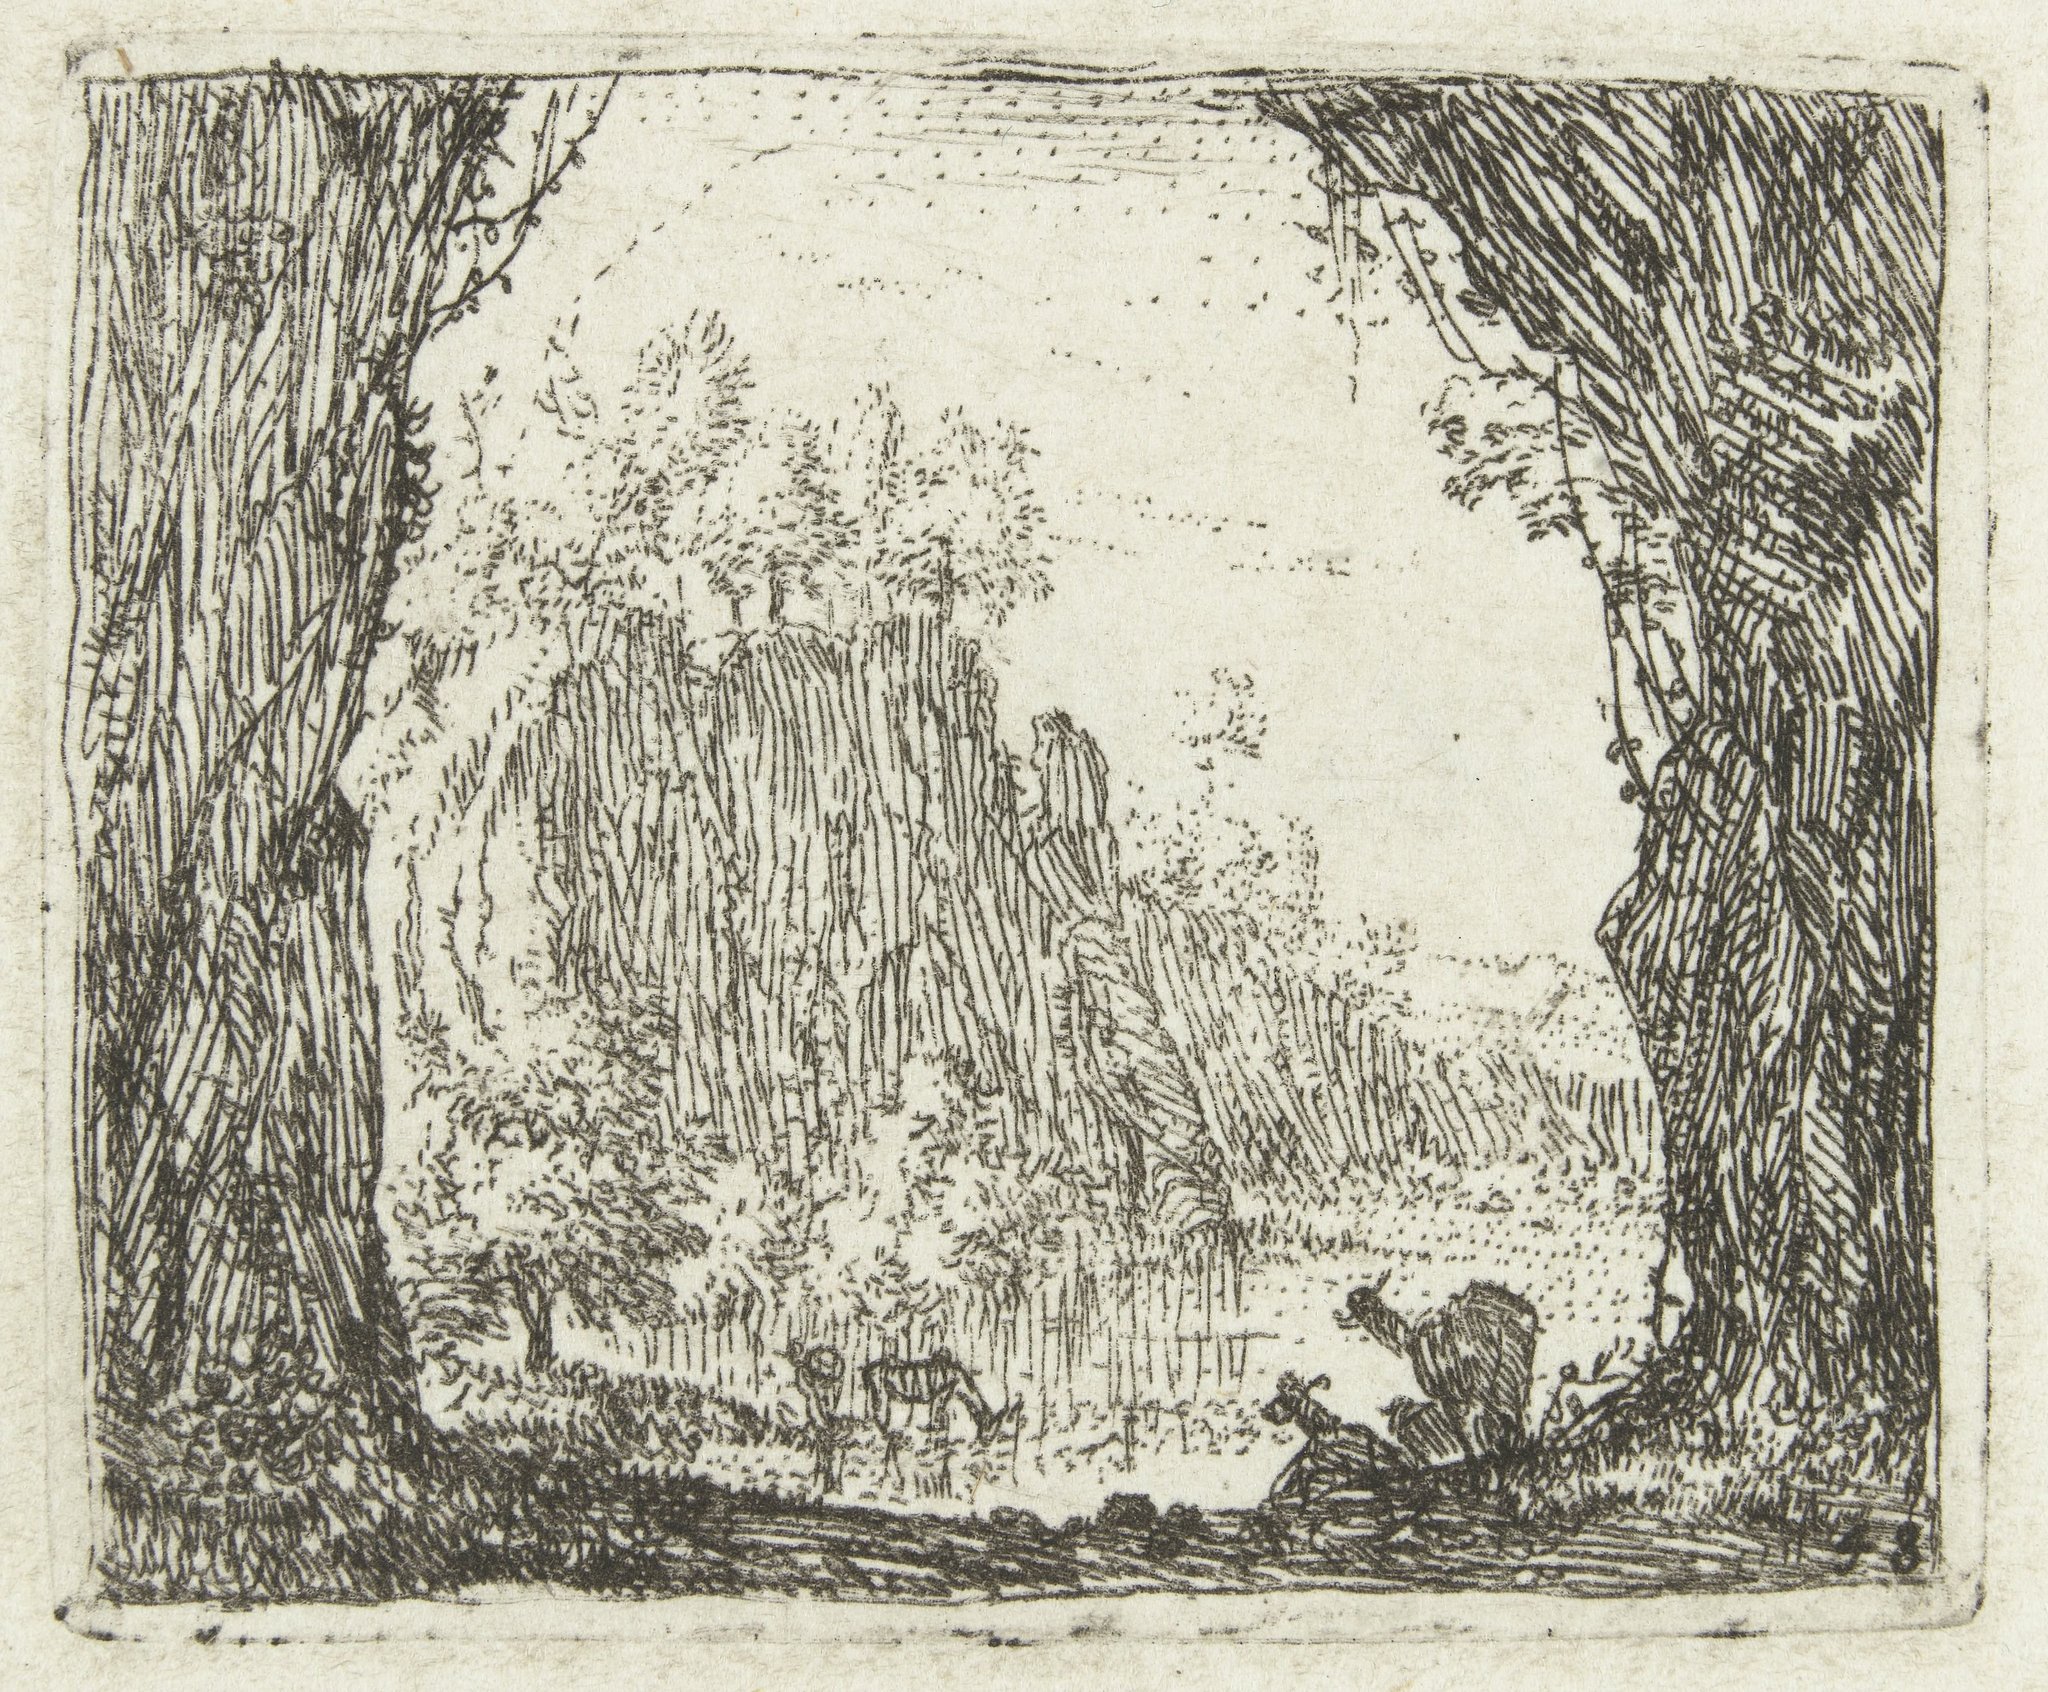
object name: print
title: Kleine landschappen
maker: karel du jardin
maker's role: draughtsman, painter, print maker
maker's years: 1626-1678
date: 1652-1659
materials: paper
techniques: etching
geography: netherlands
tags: river bank, goat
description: Maakt deel uit van blad met acht kleine etsen